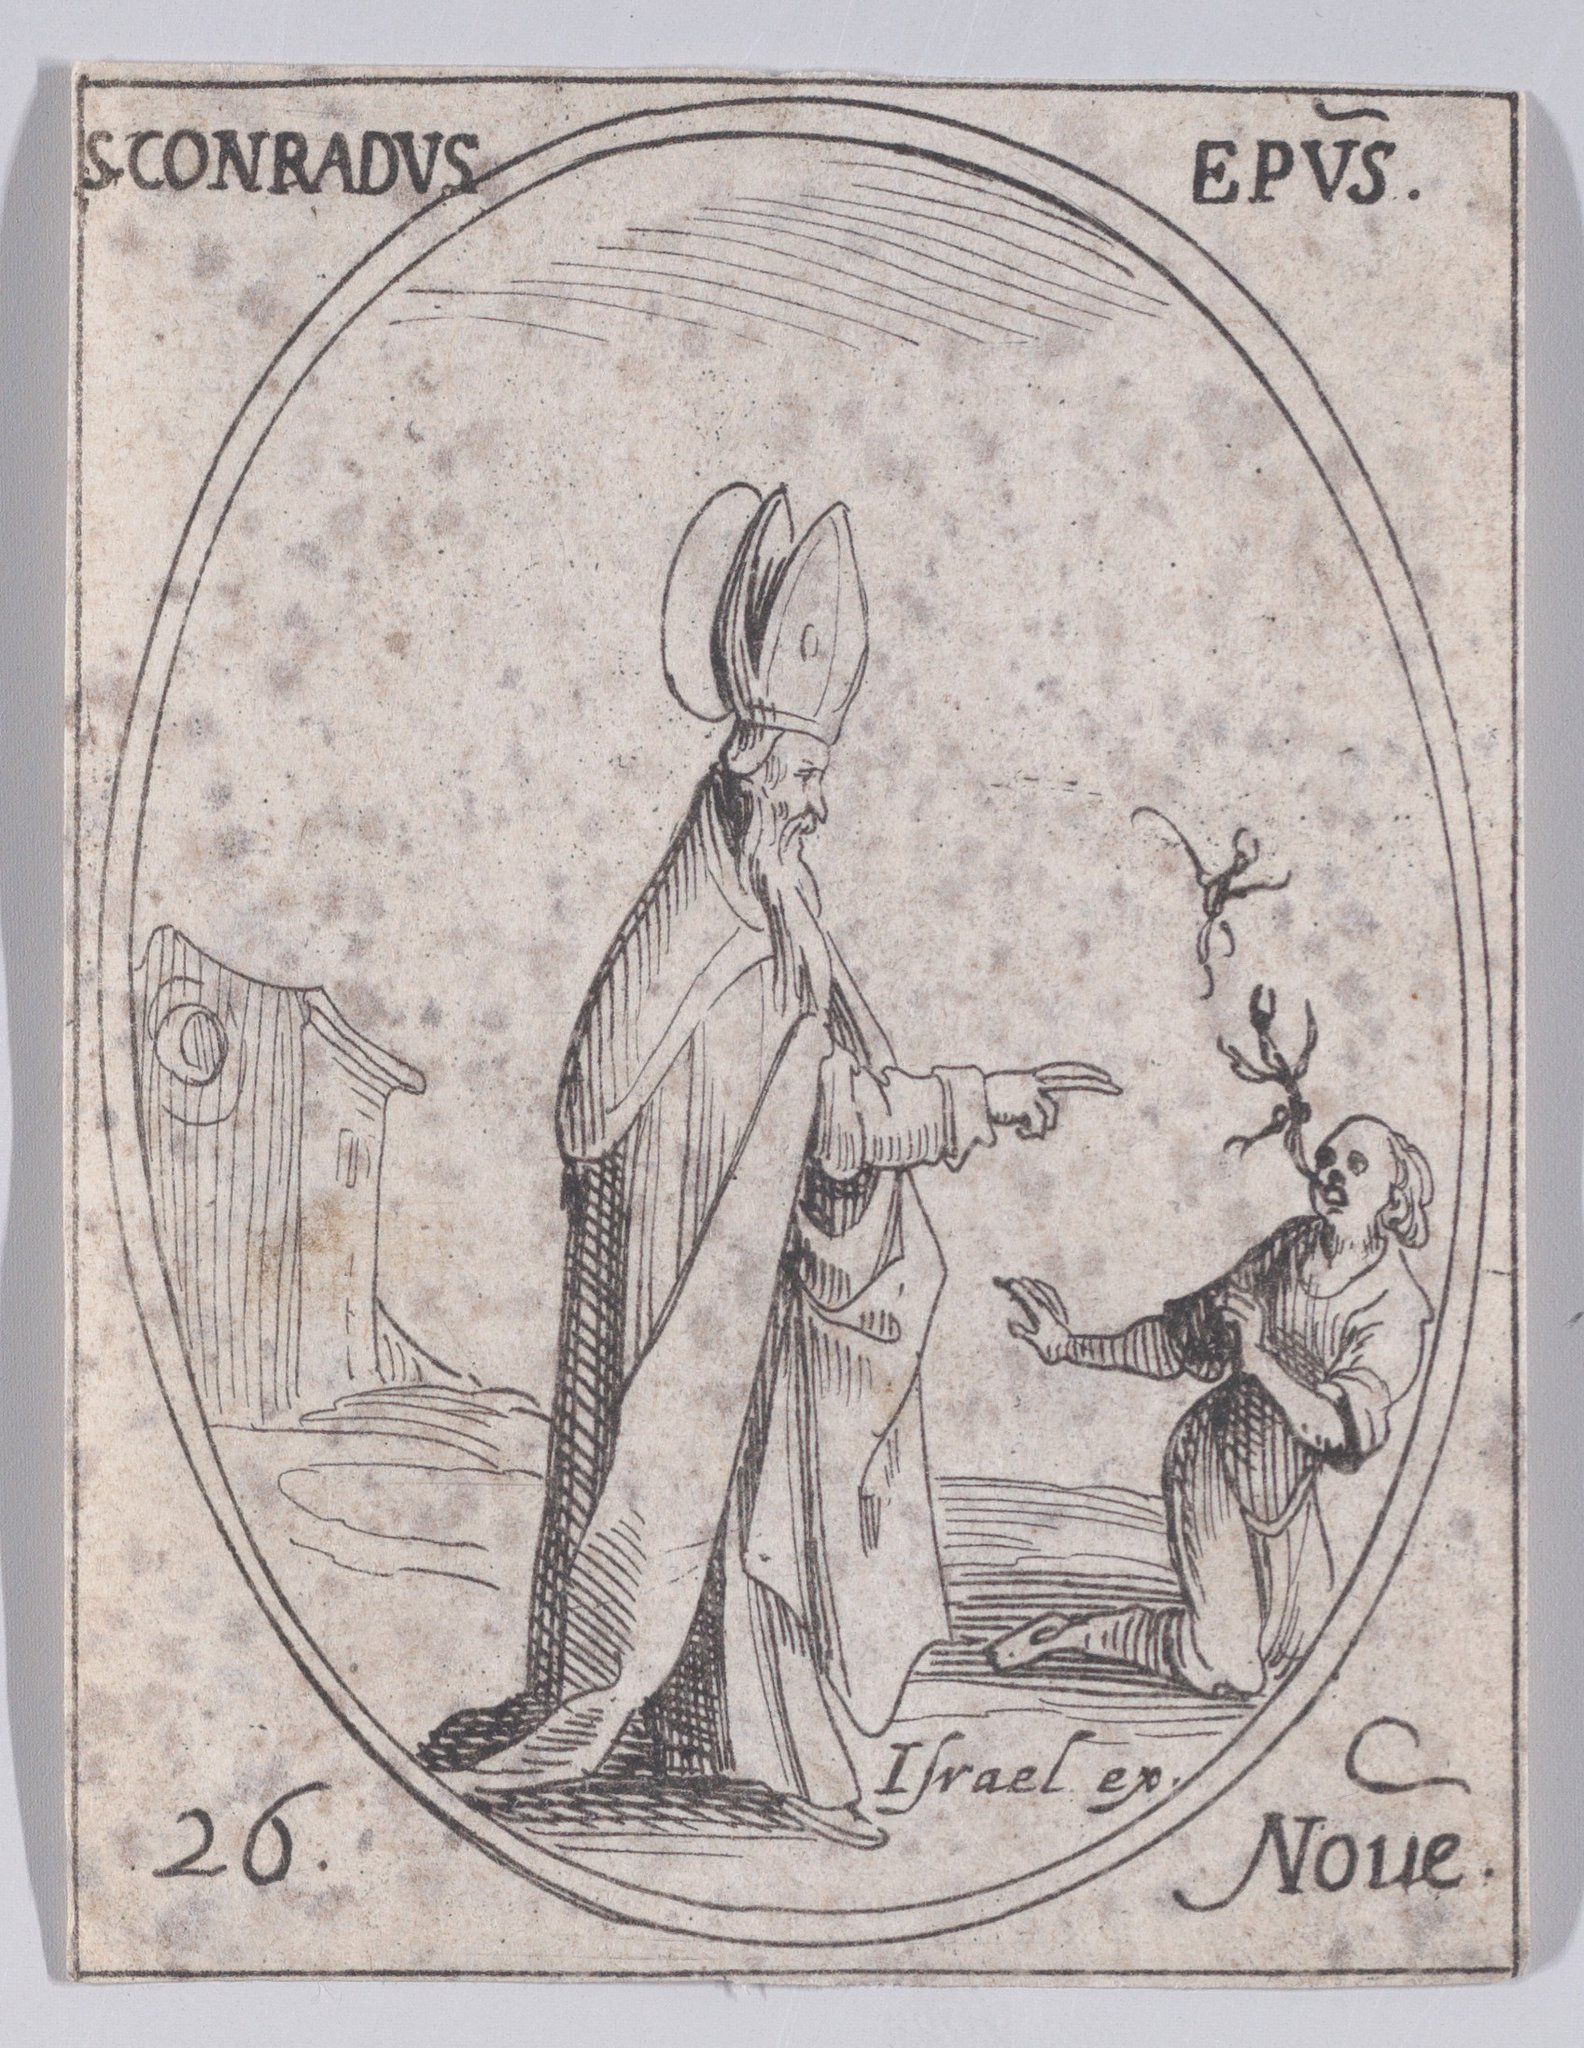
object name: print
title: S. Conrad, évêque (St. Conrad, Bishop), November 26th, from "Les Images De Tous Les Saincts et Saintes de L'Année" (Images of All of the Saints and Religious Events of the Year)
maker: jacques callot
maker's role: artist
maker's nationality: french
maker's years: 1592-1635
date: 1636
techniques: etching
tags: men,bishops,saints